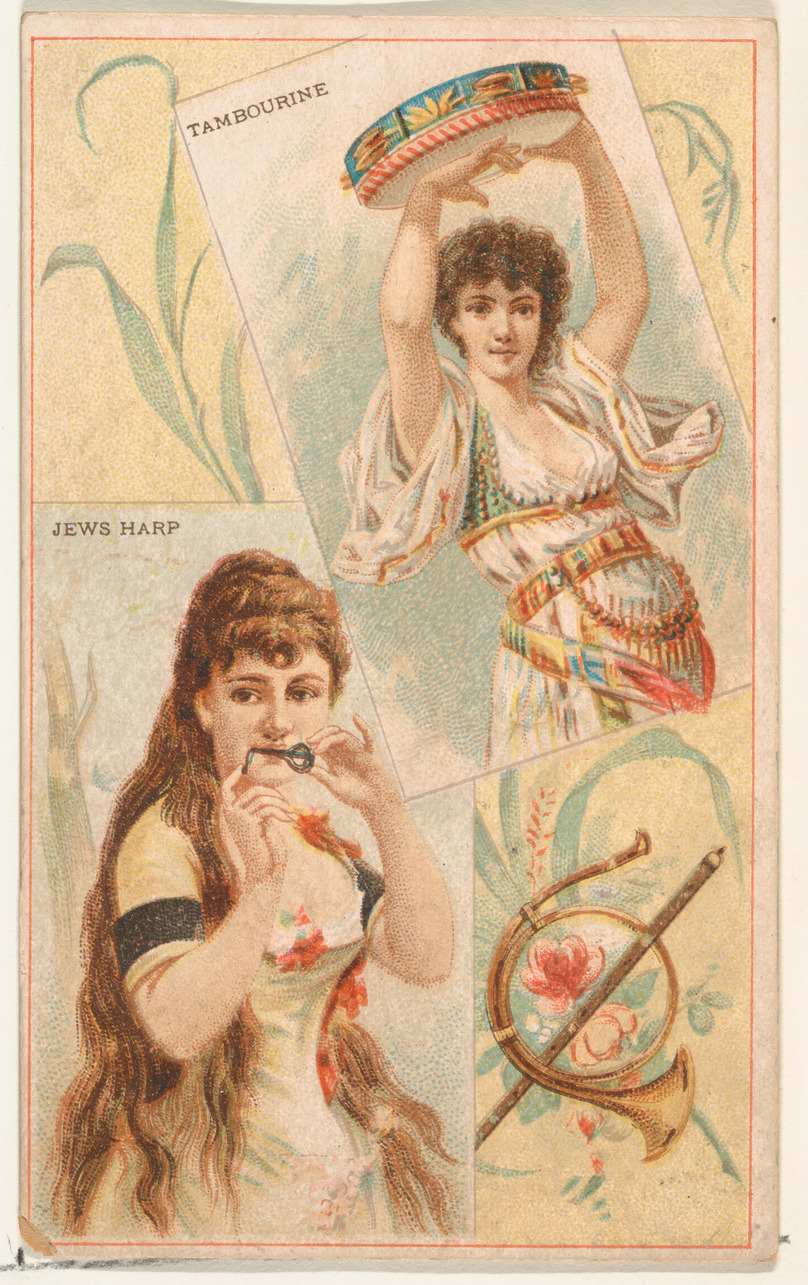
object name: print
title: Jews Harp and Tambourine, from the Musical Instruments series (N121) issued by Duke Sons & Co. to promote Honest Long Cut Tobacco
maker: w. duke, sons & co.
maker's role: publisher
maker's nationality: american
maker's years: 1870-1920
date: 1888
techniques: color lithograph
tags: women,harps